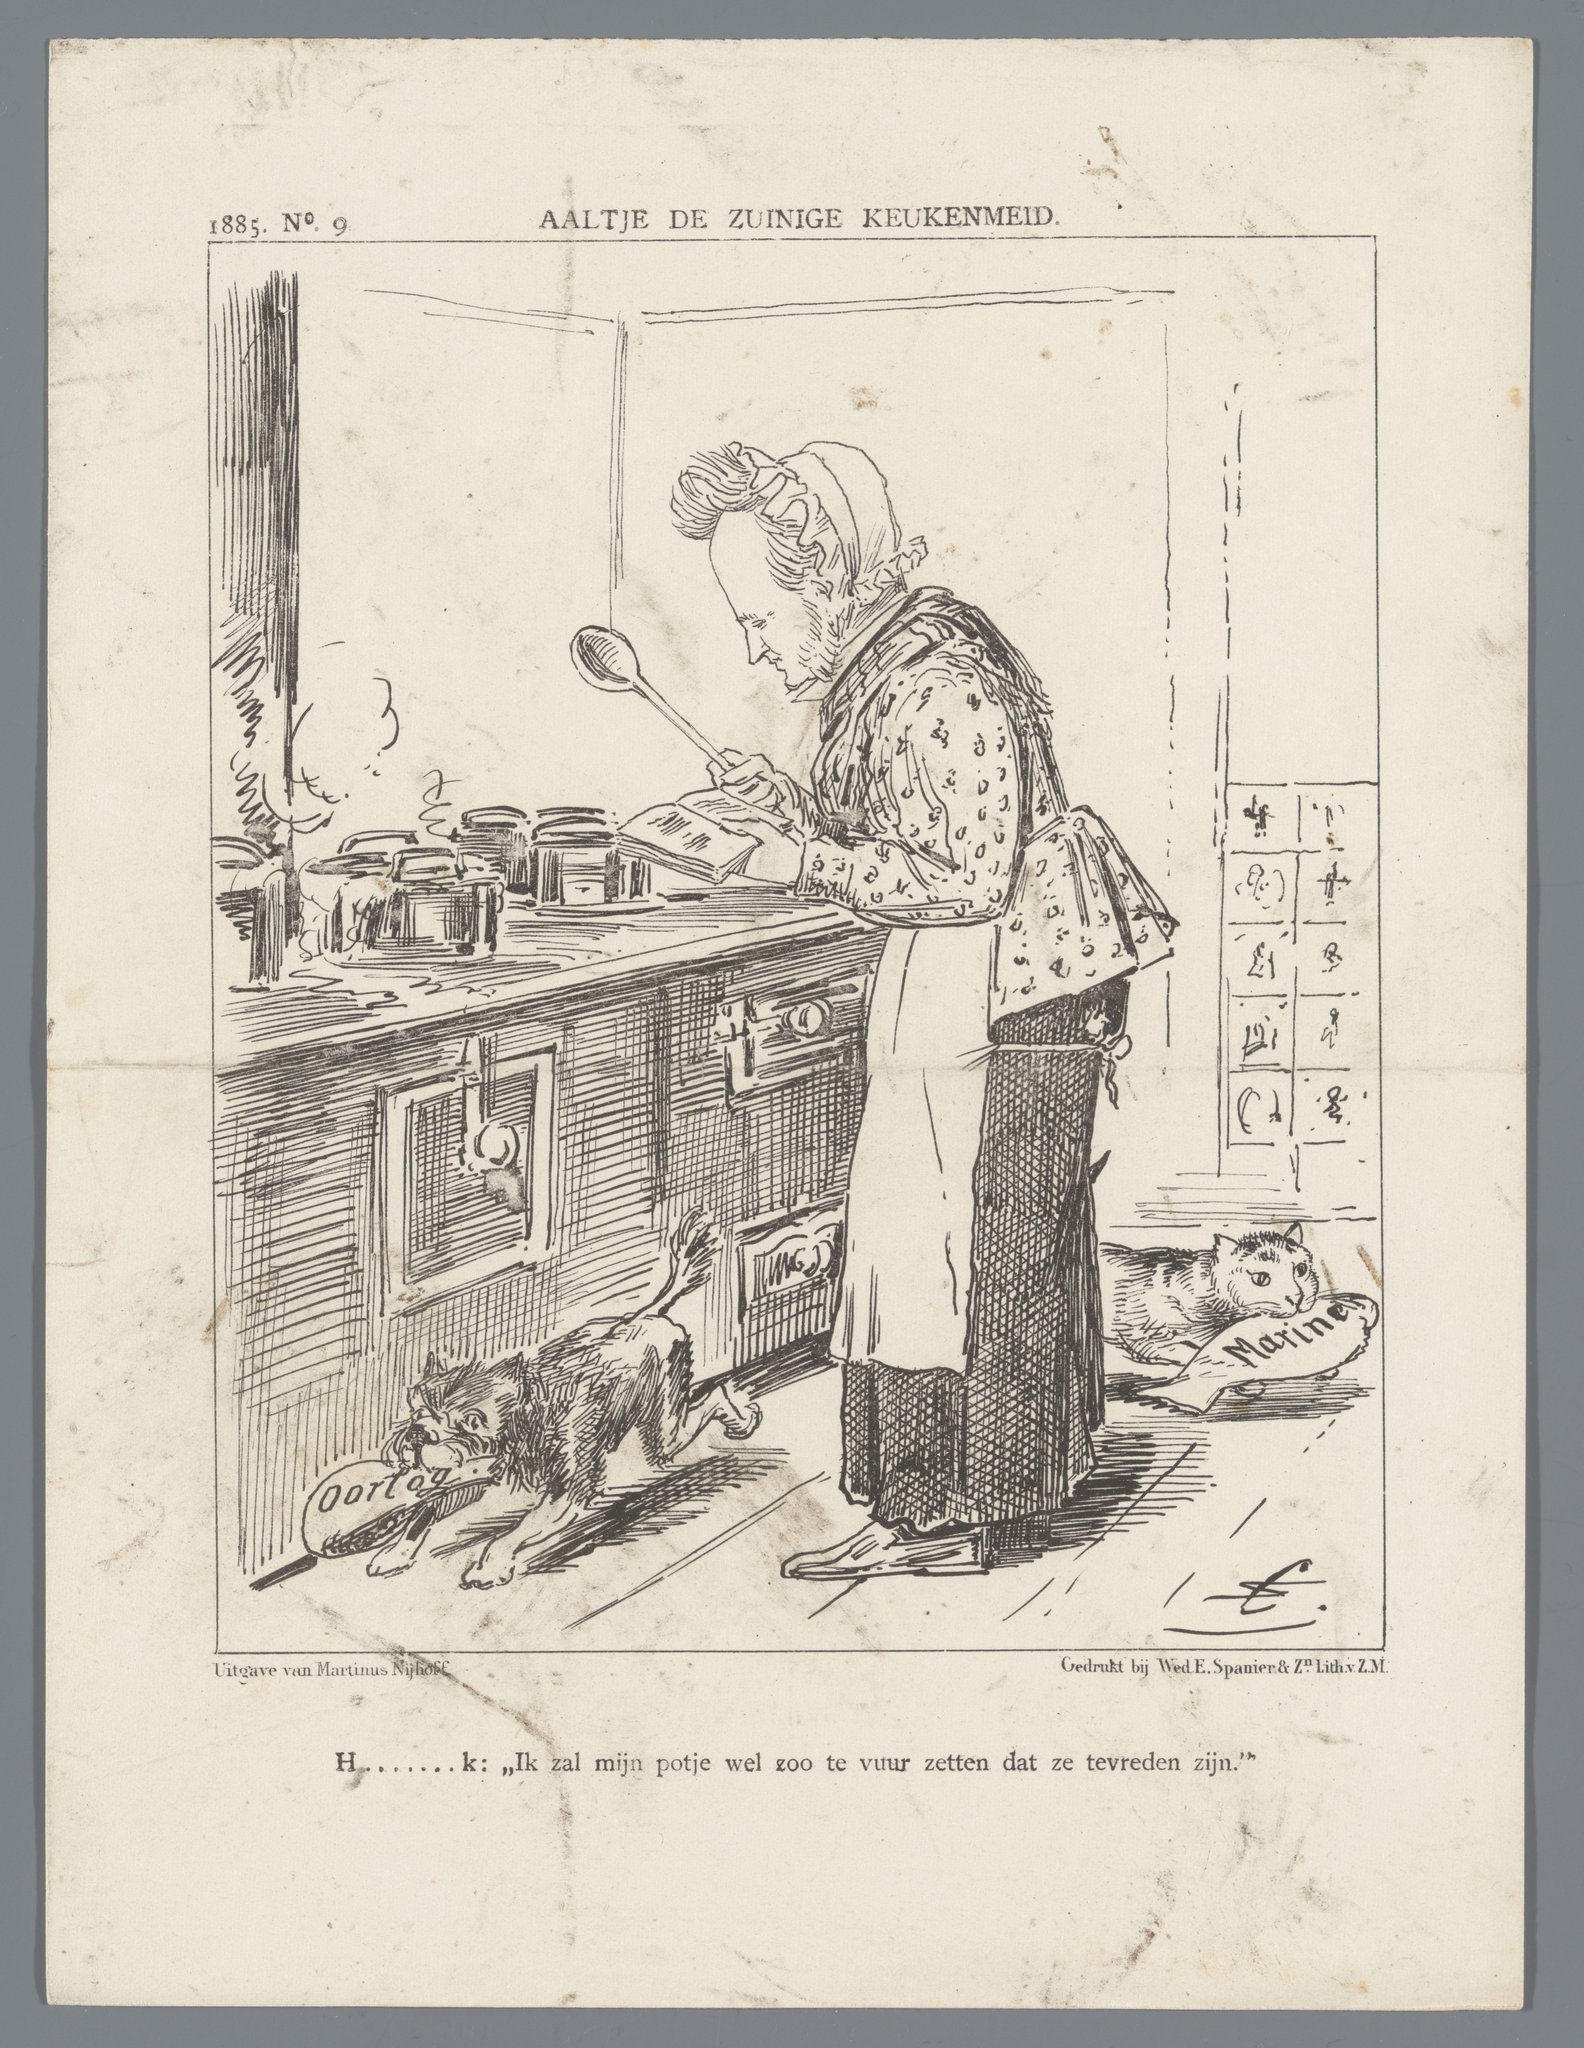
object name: print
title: Aaltje de zuinige keukenmeid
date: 1885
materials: paper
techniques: lithograph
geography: the hague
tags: politician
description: Spotprent op Heemskerk als Aaltje de zuinige keukenmeid. Plaat verschenen bij het weekblad De Nederlandsche Spectator, nr. 9, 1885.